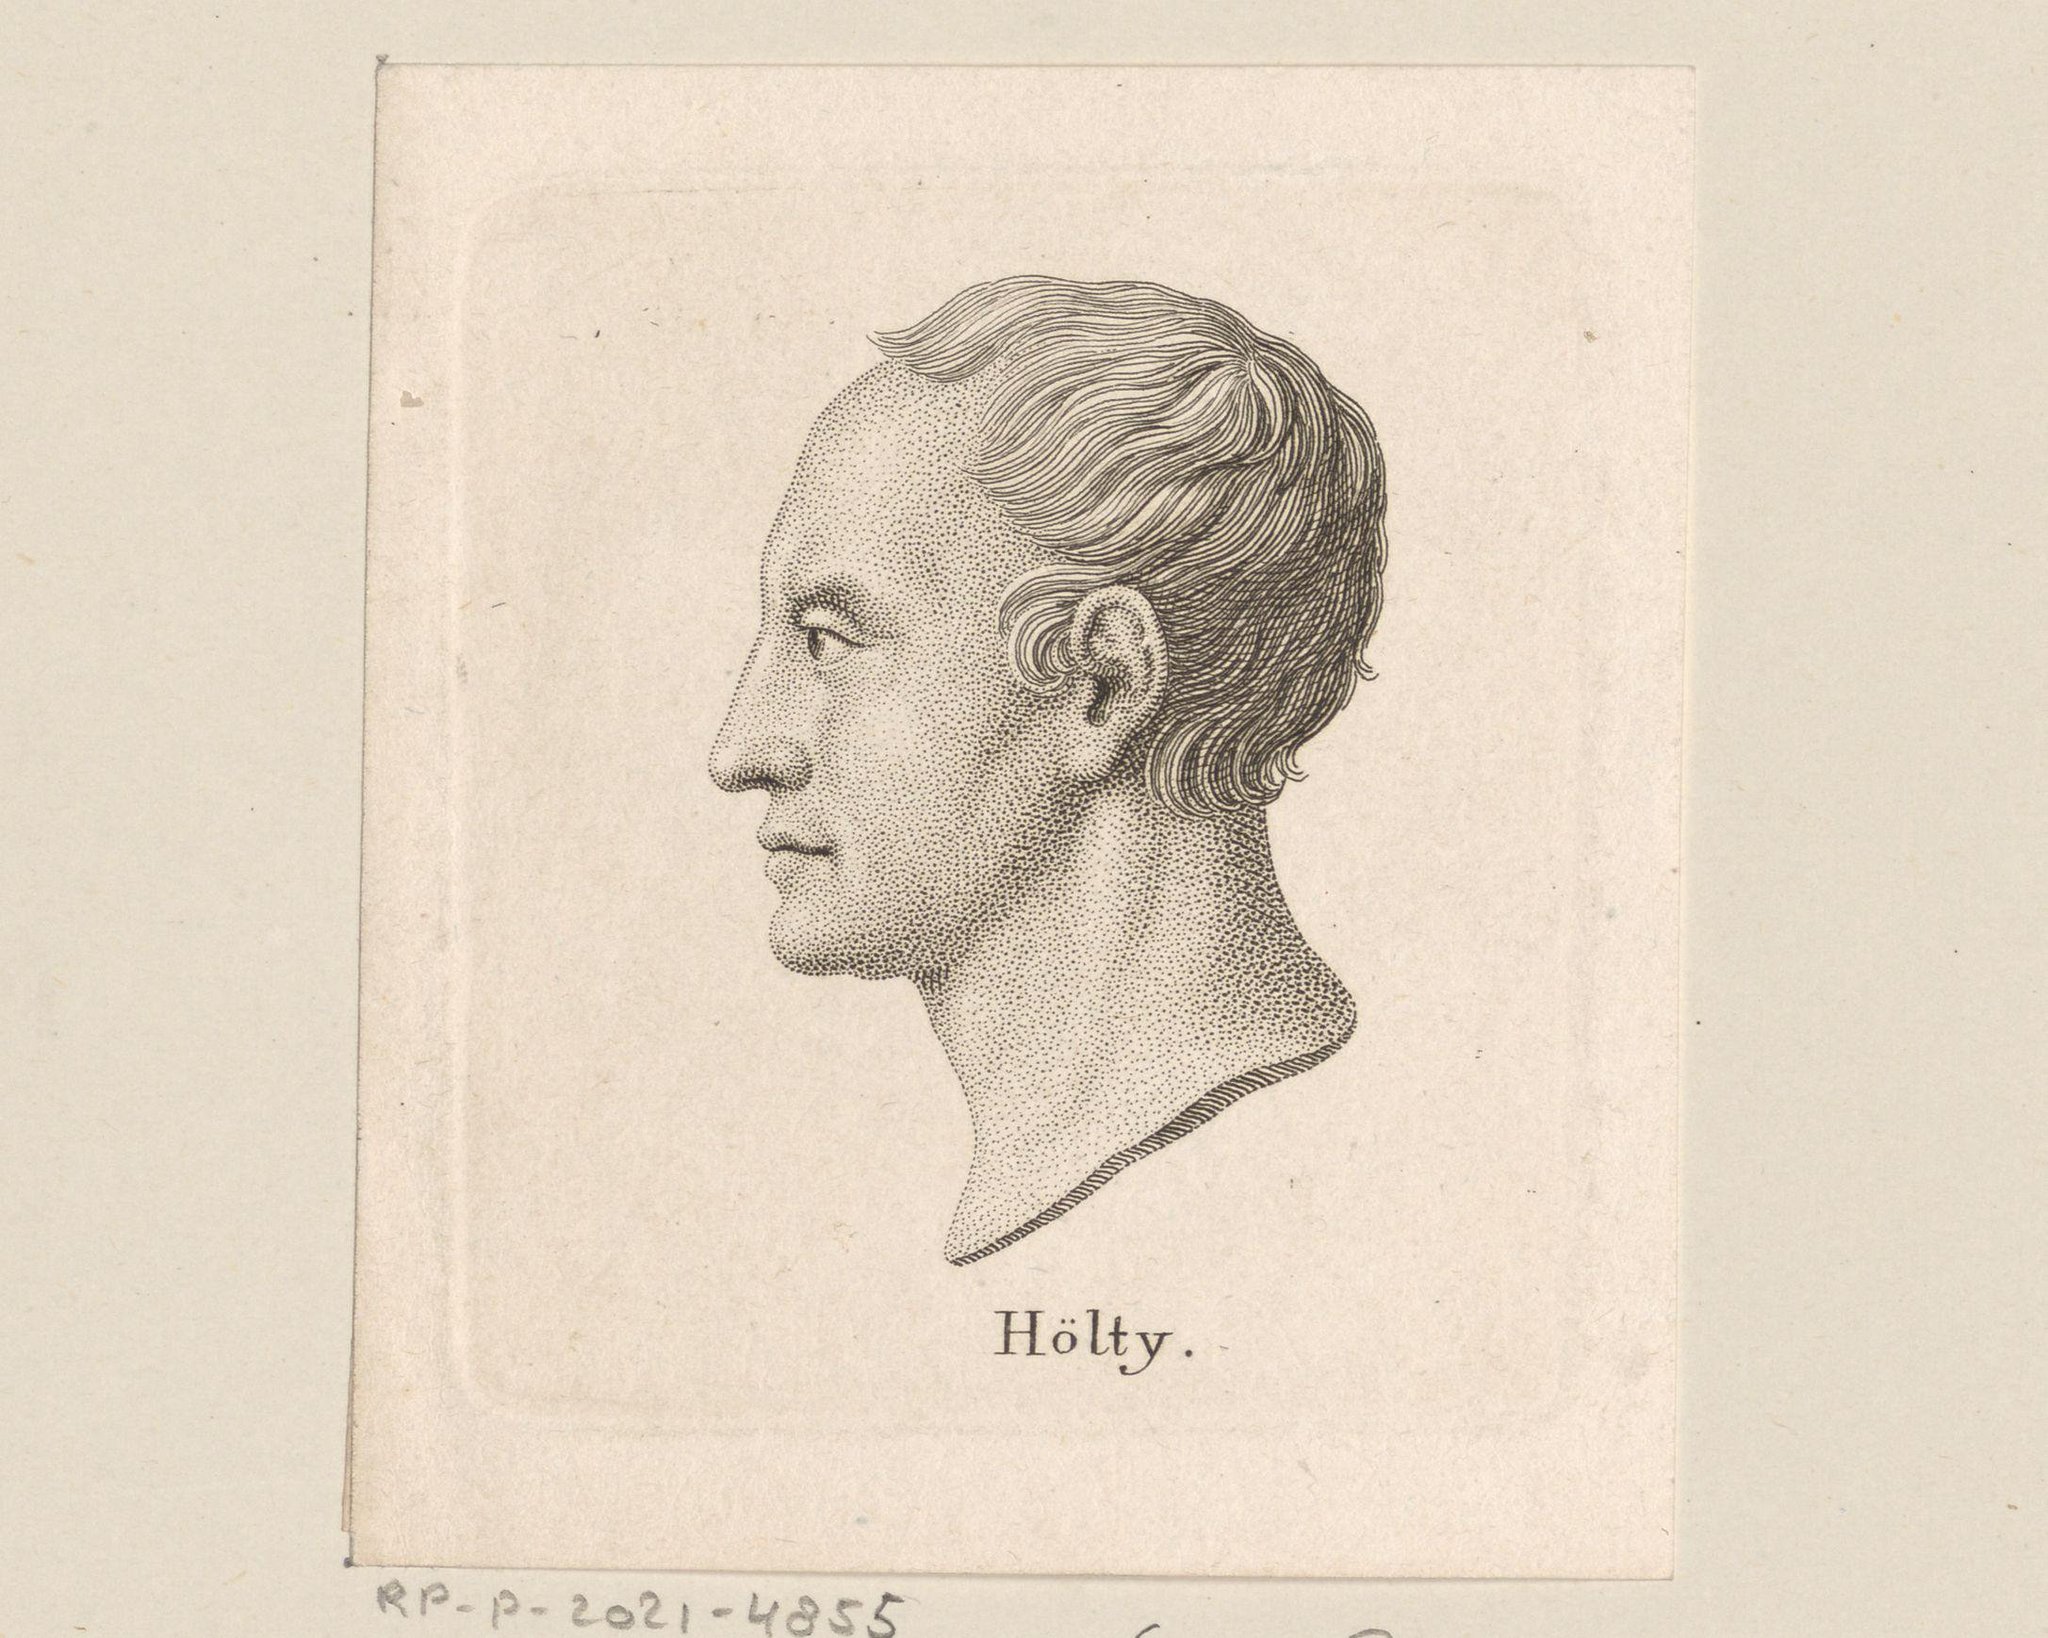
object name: print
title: Portret van Ludwig Hölty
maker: Anonymous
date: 1800-1849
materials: paper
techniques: etching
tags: historical persons, writer, poet, author